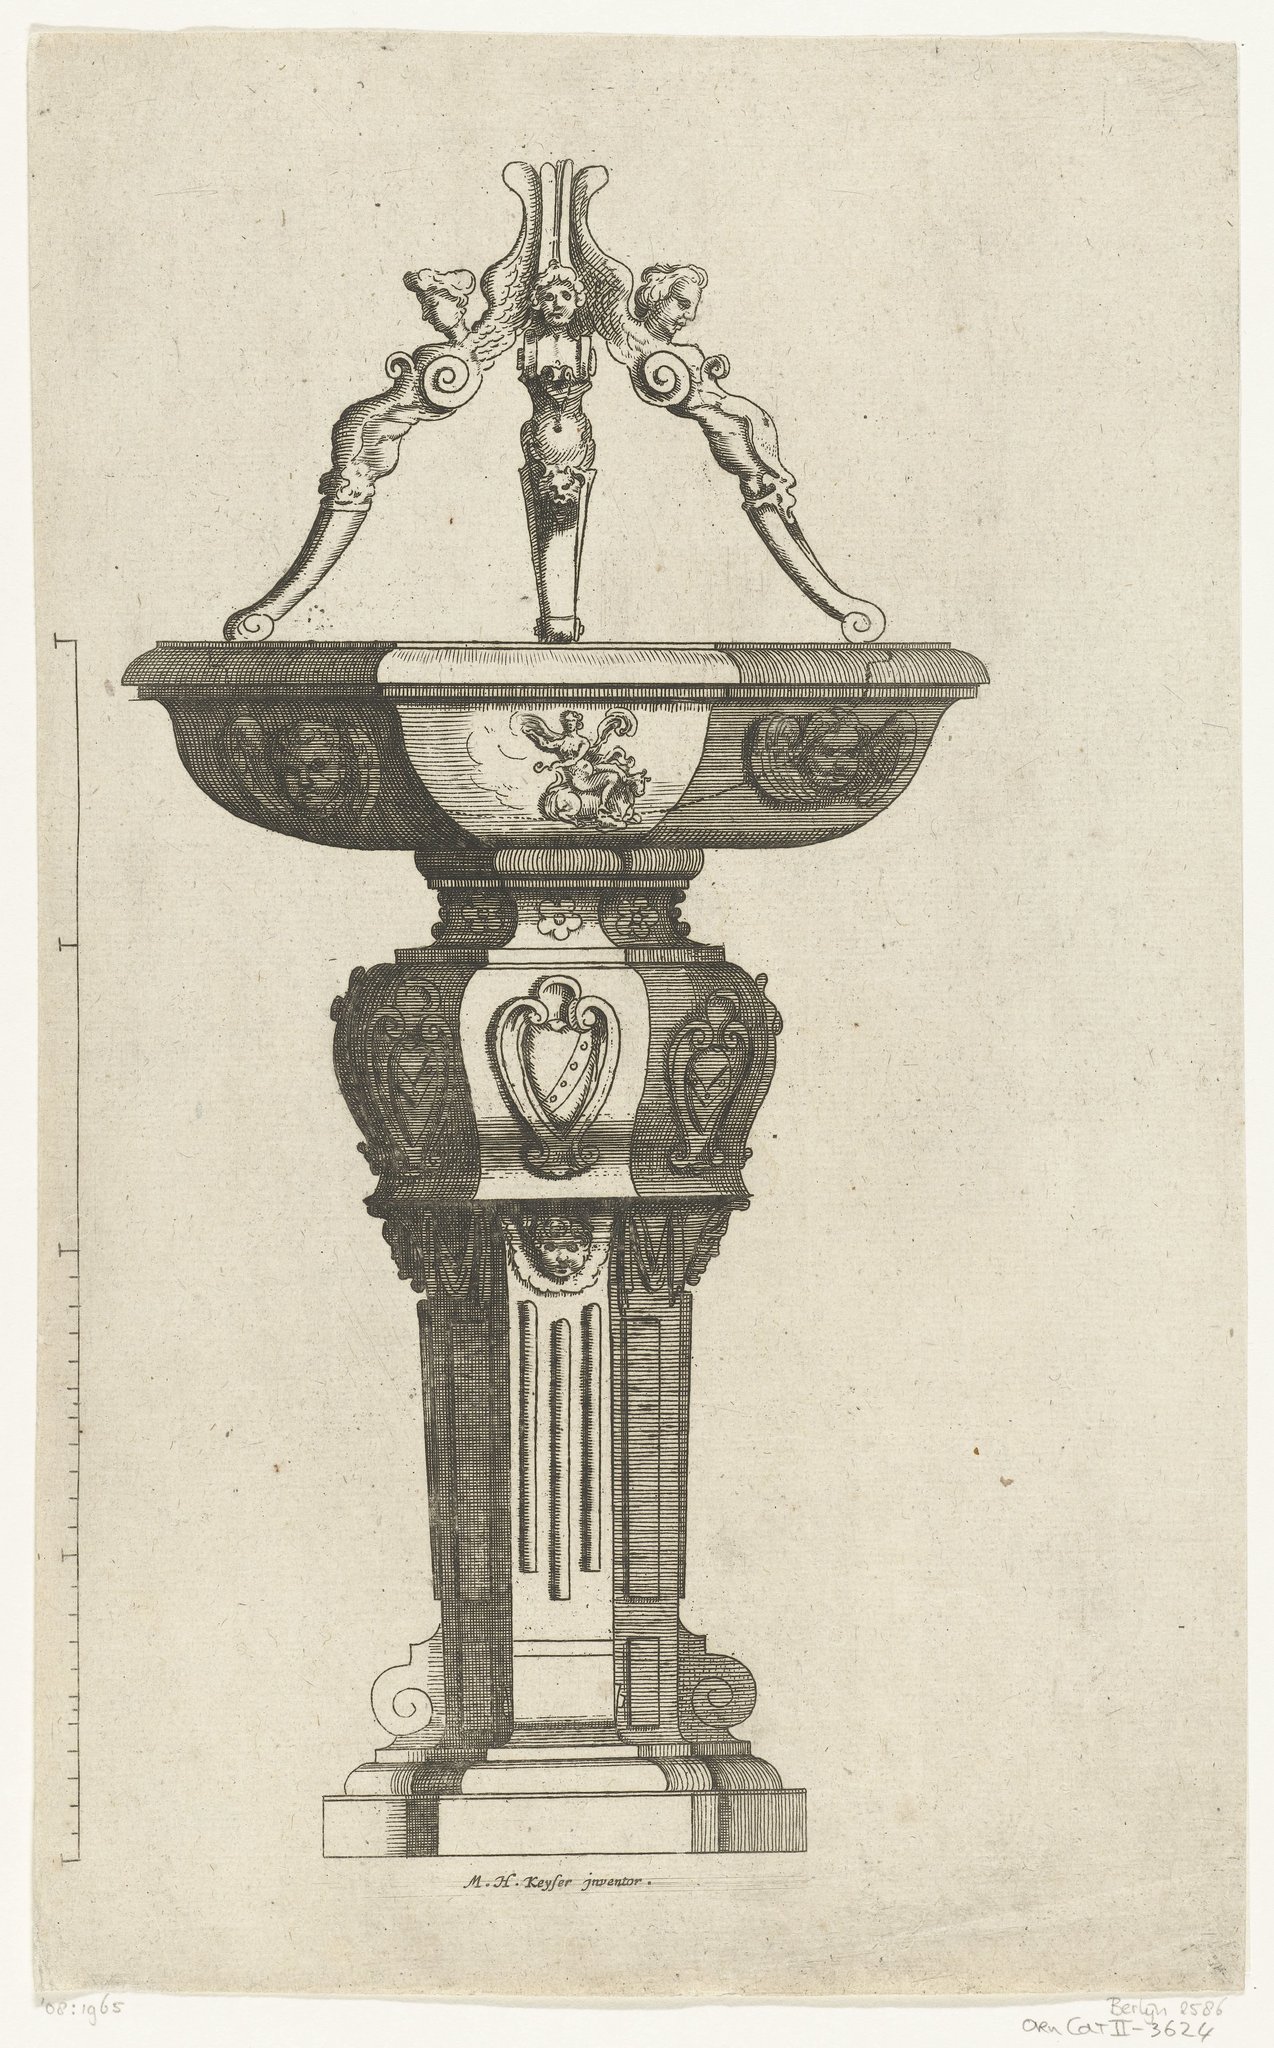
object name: ornament print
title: Reghel vande vijf Ordens der Architecture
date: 1575-1629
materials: paper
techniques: etching